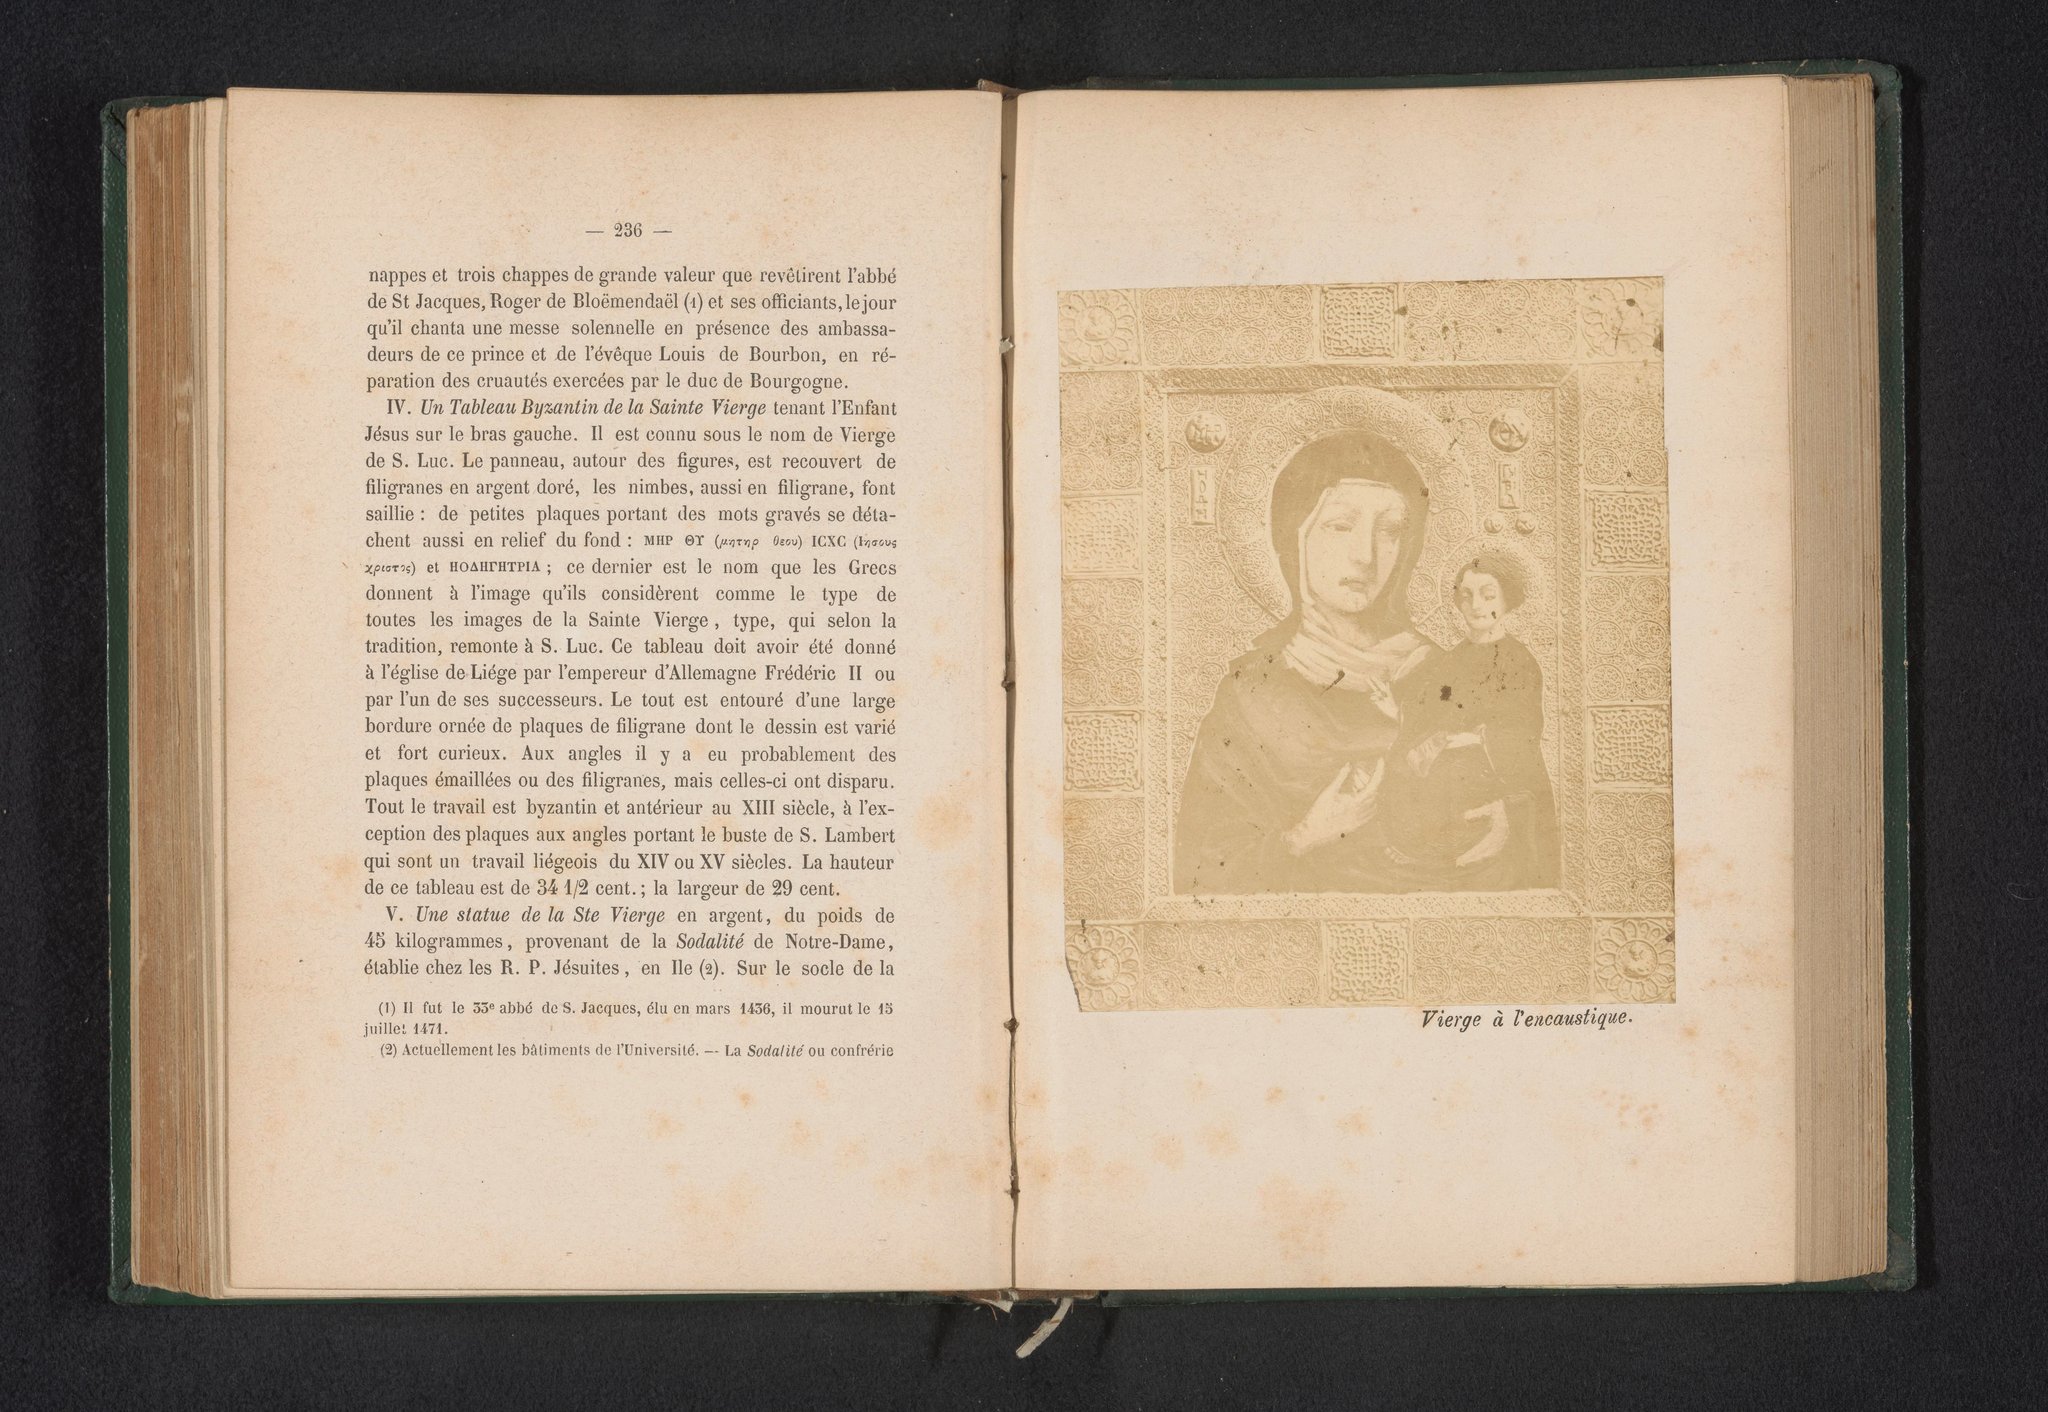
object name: page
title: Fotoreproductie van een Maria met Christus op de arm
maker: Anonymous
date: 1862-1867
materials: photographic support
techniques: albumen print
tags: mary standing (or half-length), the christ-child on her arm (christ-child to mary's left)